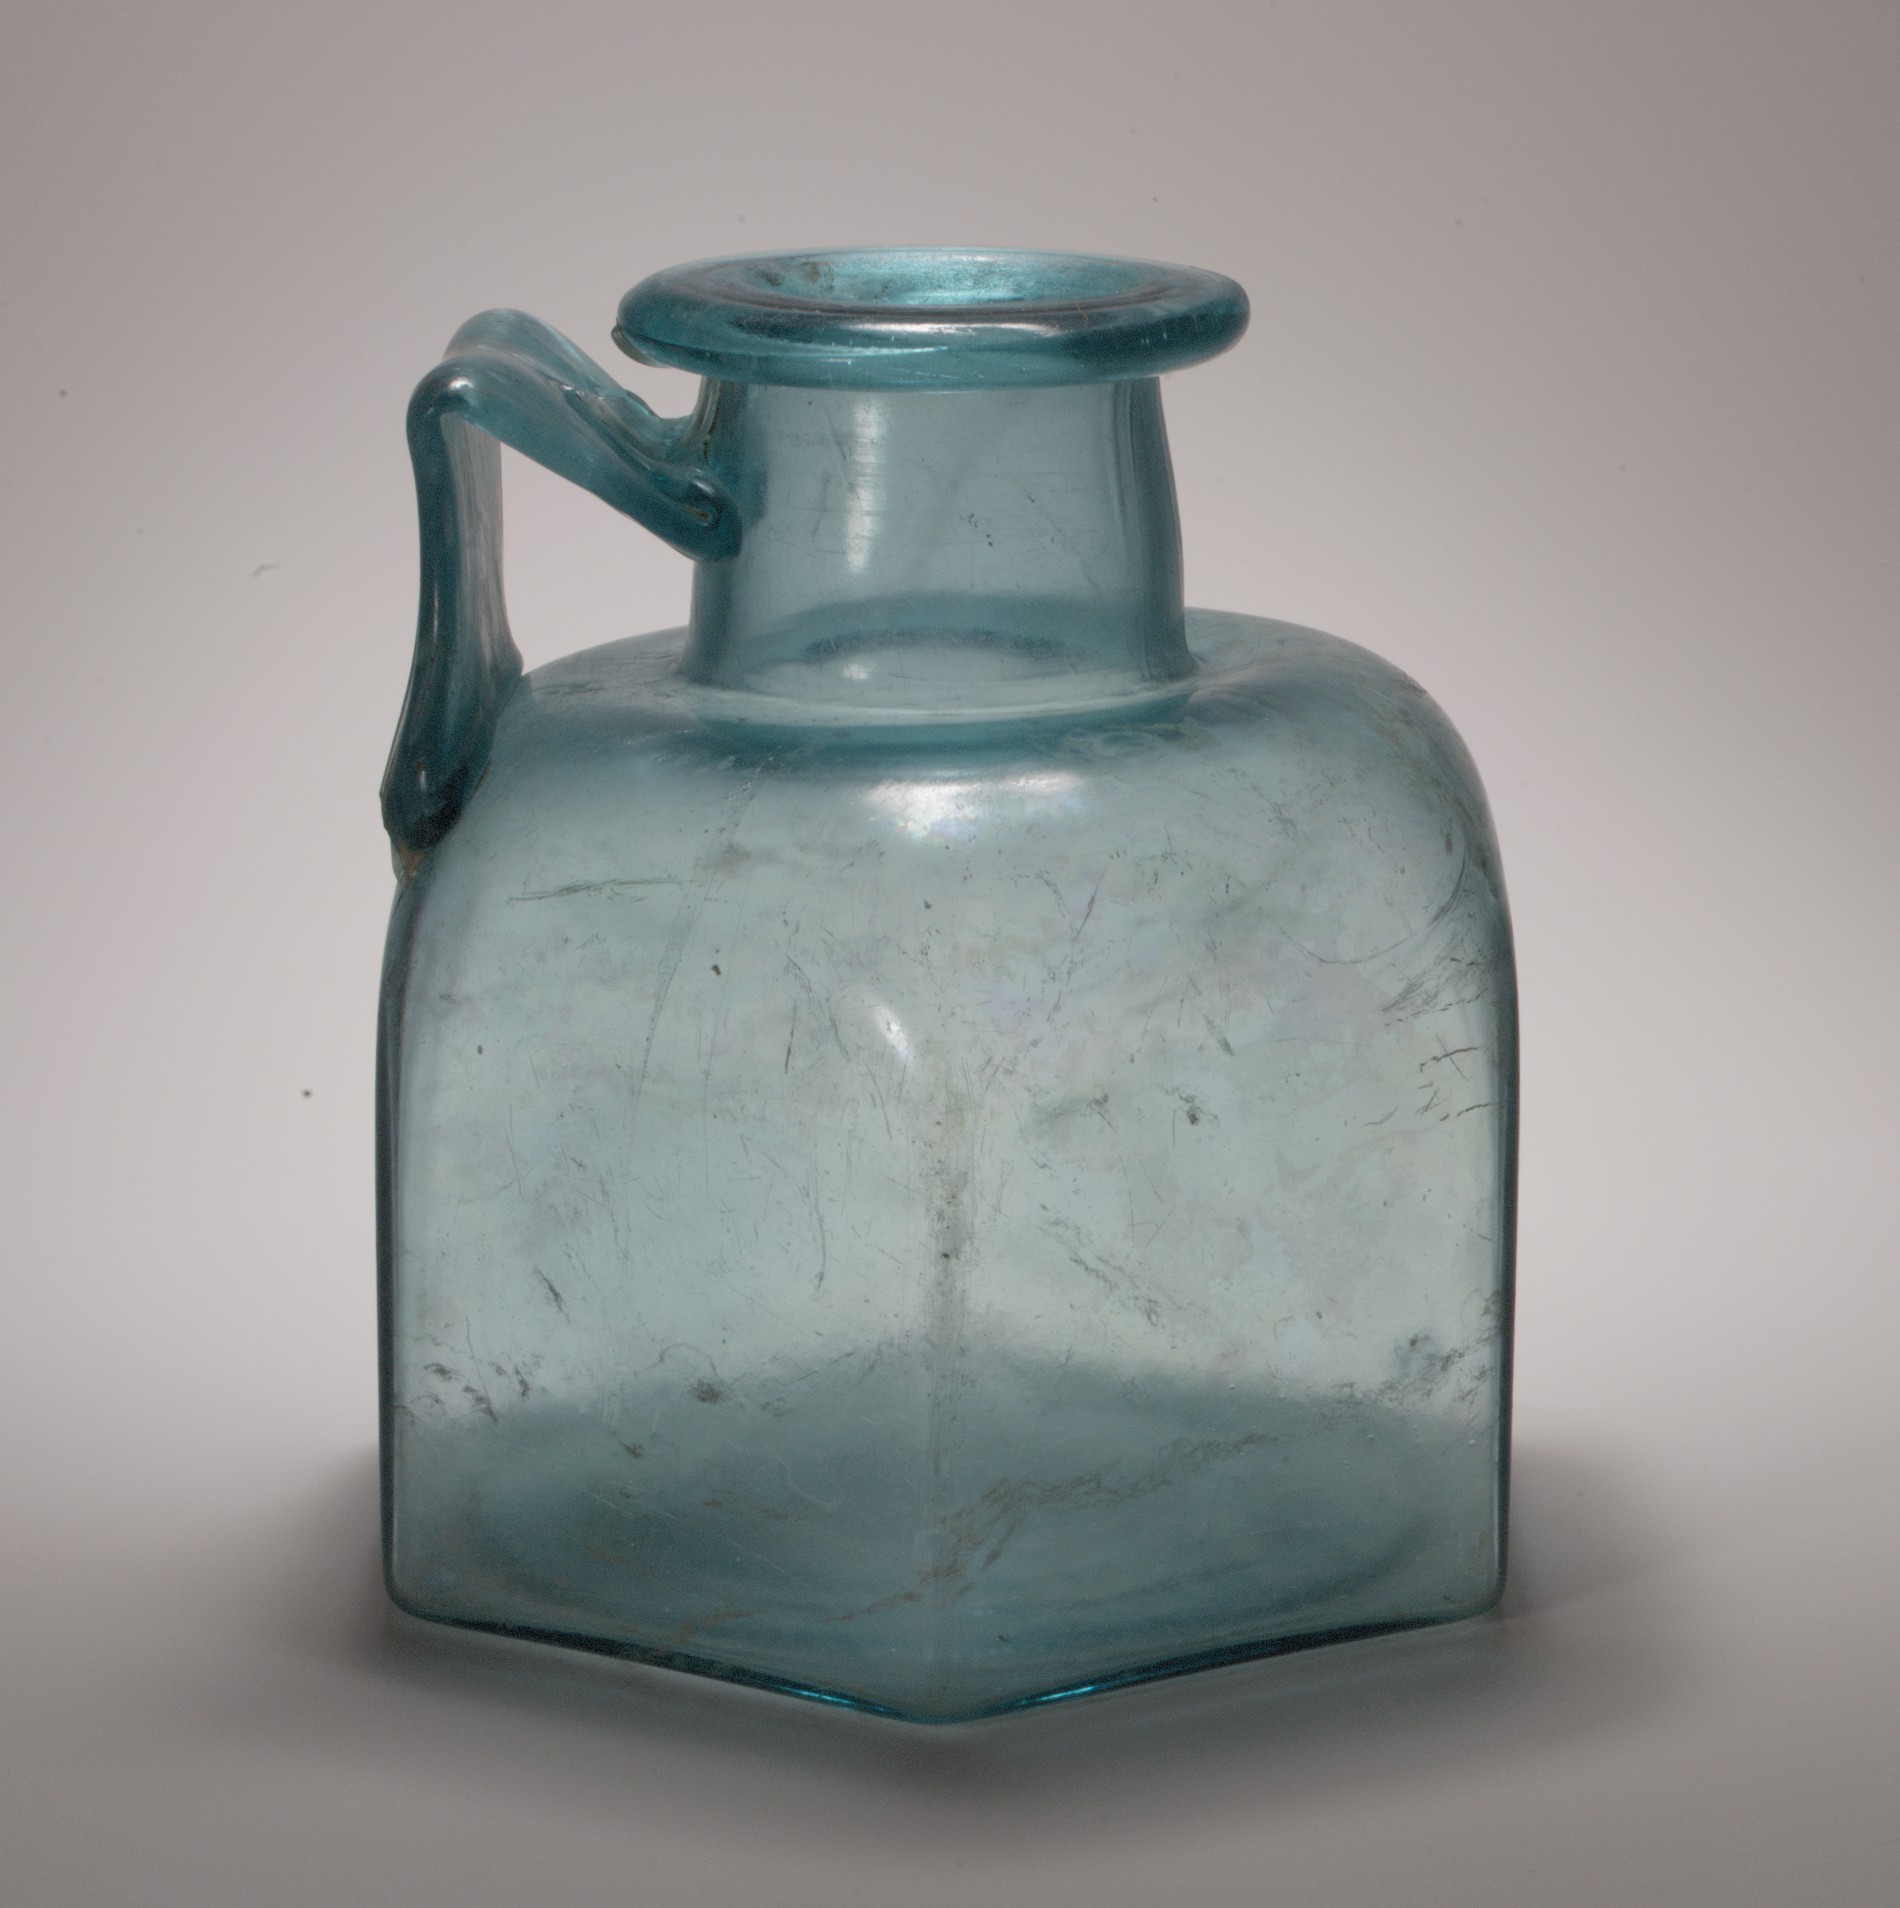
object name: bottle, hexagonal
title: Glass one-handled hexagonal bottle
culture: roman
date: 67-233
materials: glass